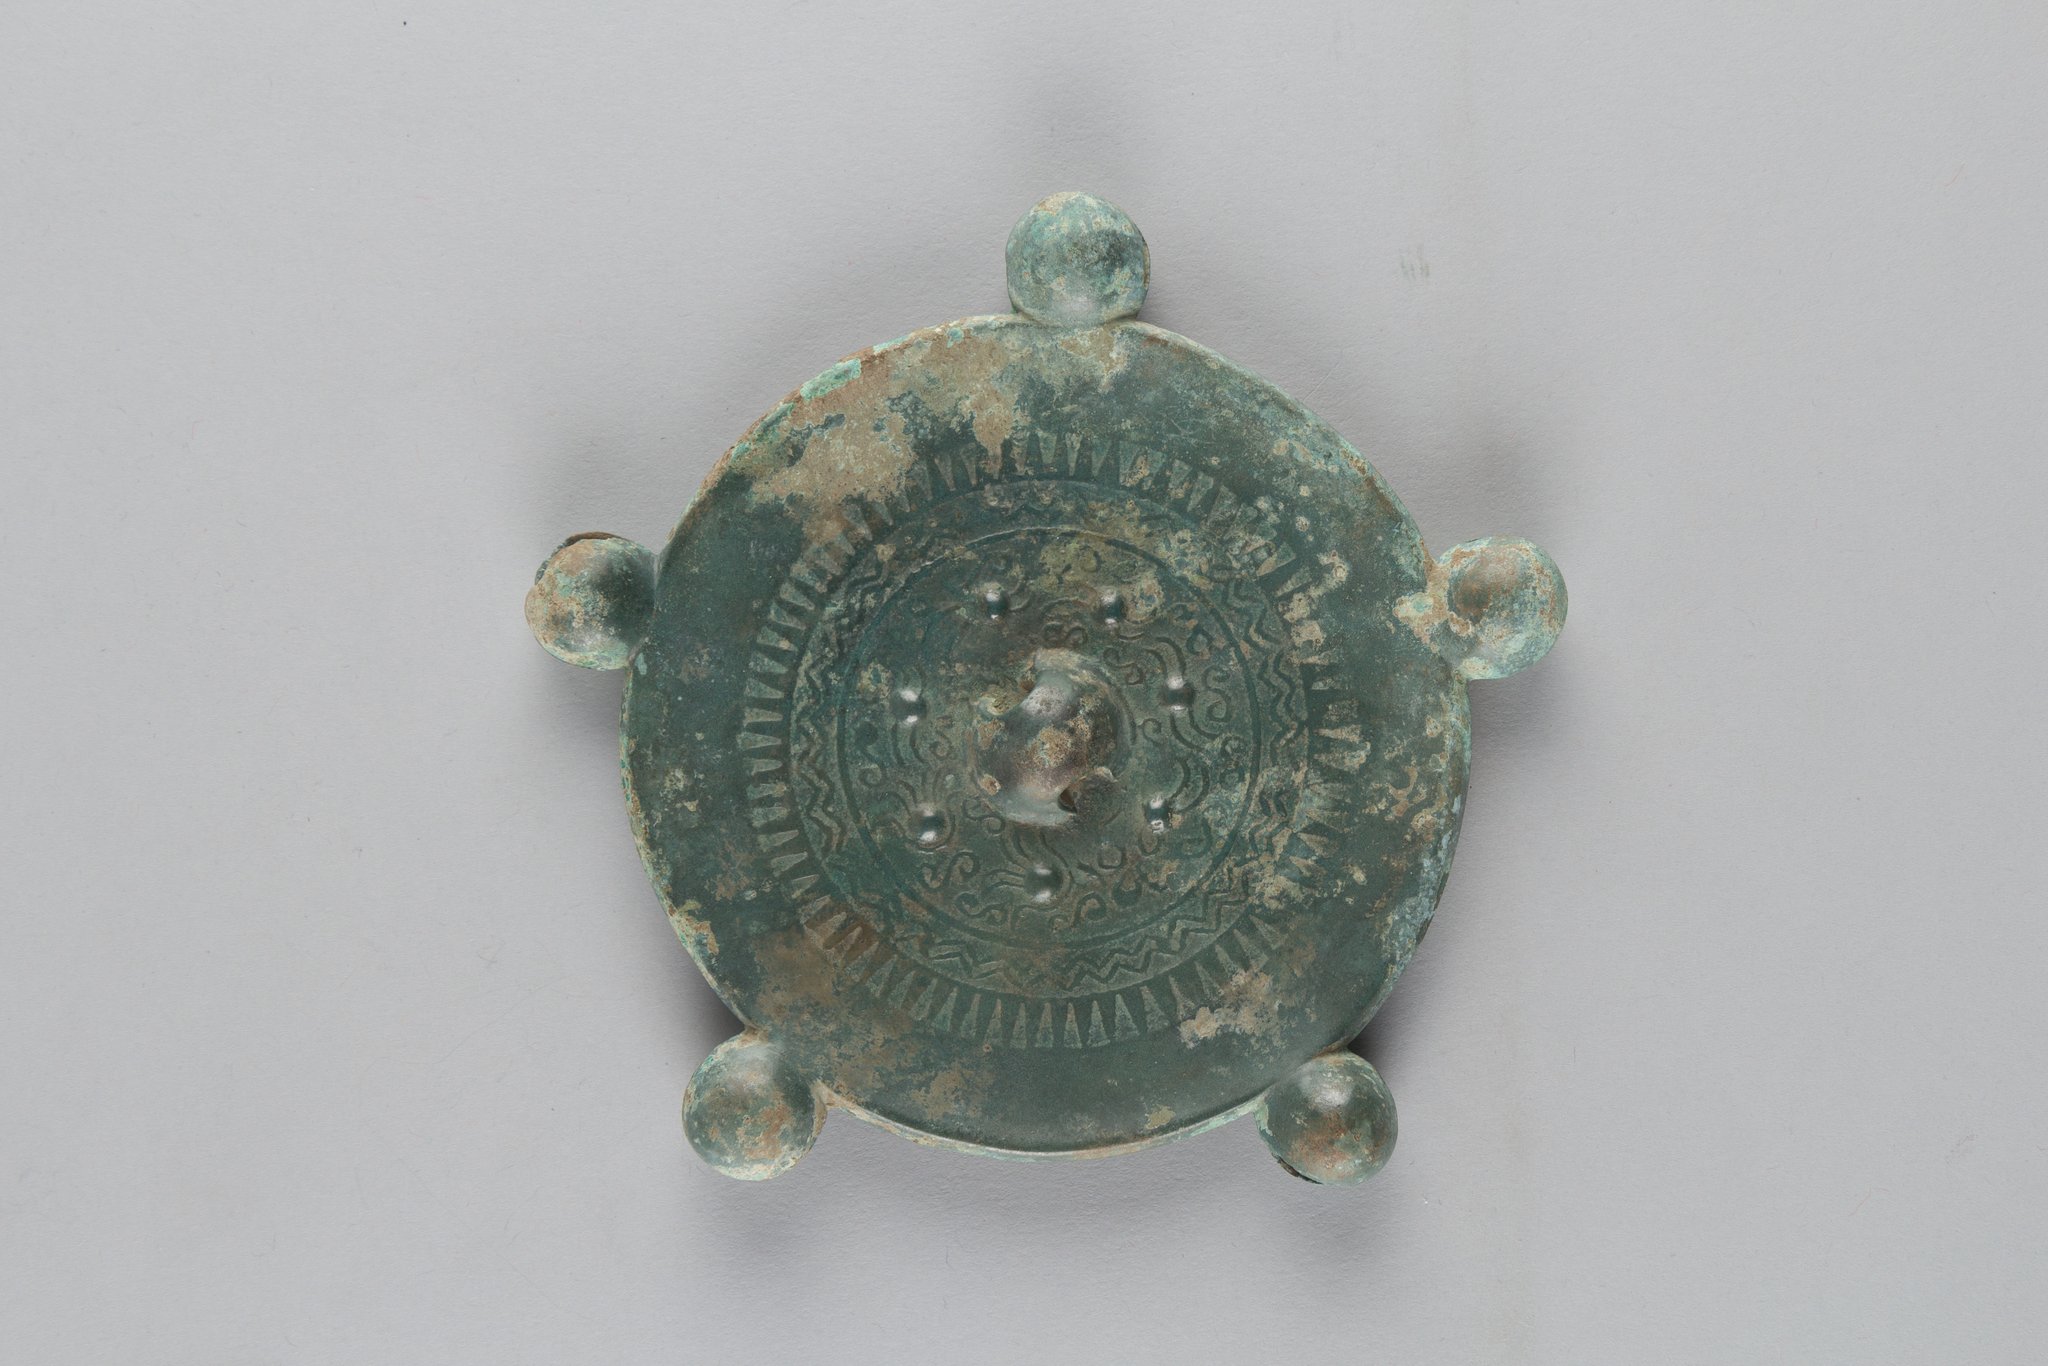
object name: mirror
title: Mirror with Five Bells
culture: japanese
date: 501-533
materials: bronze